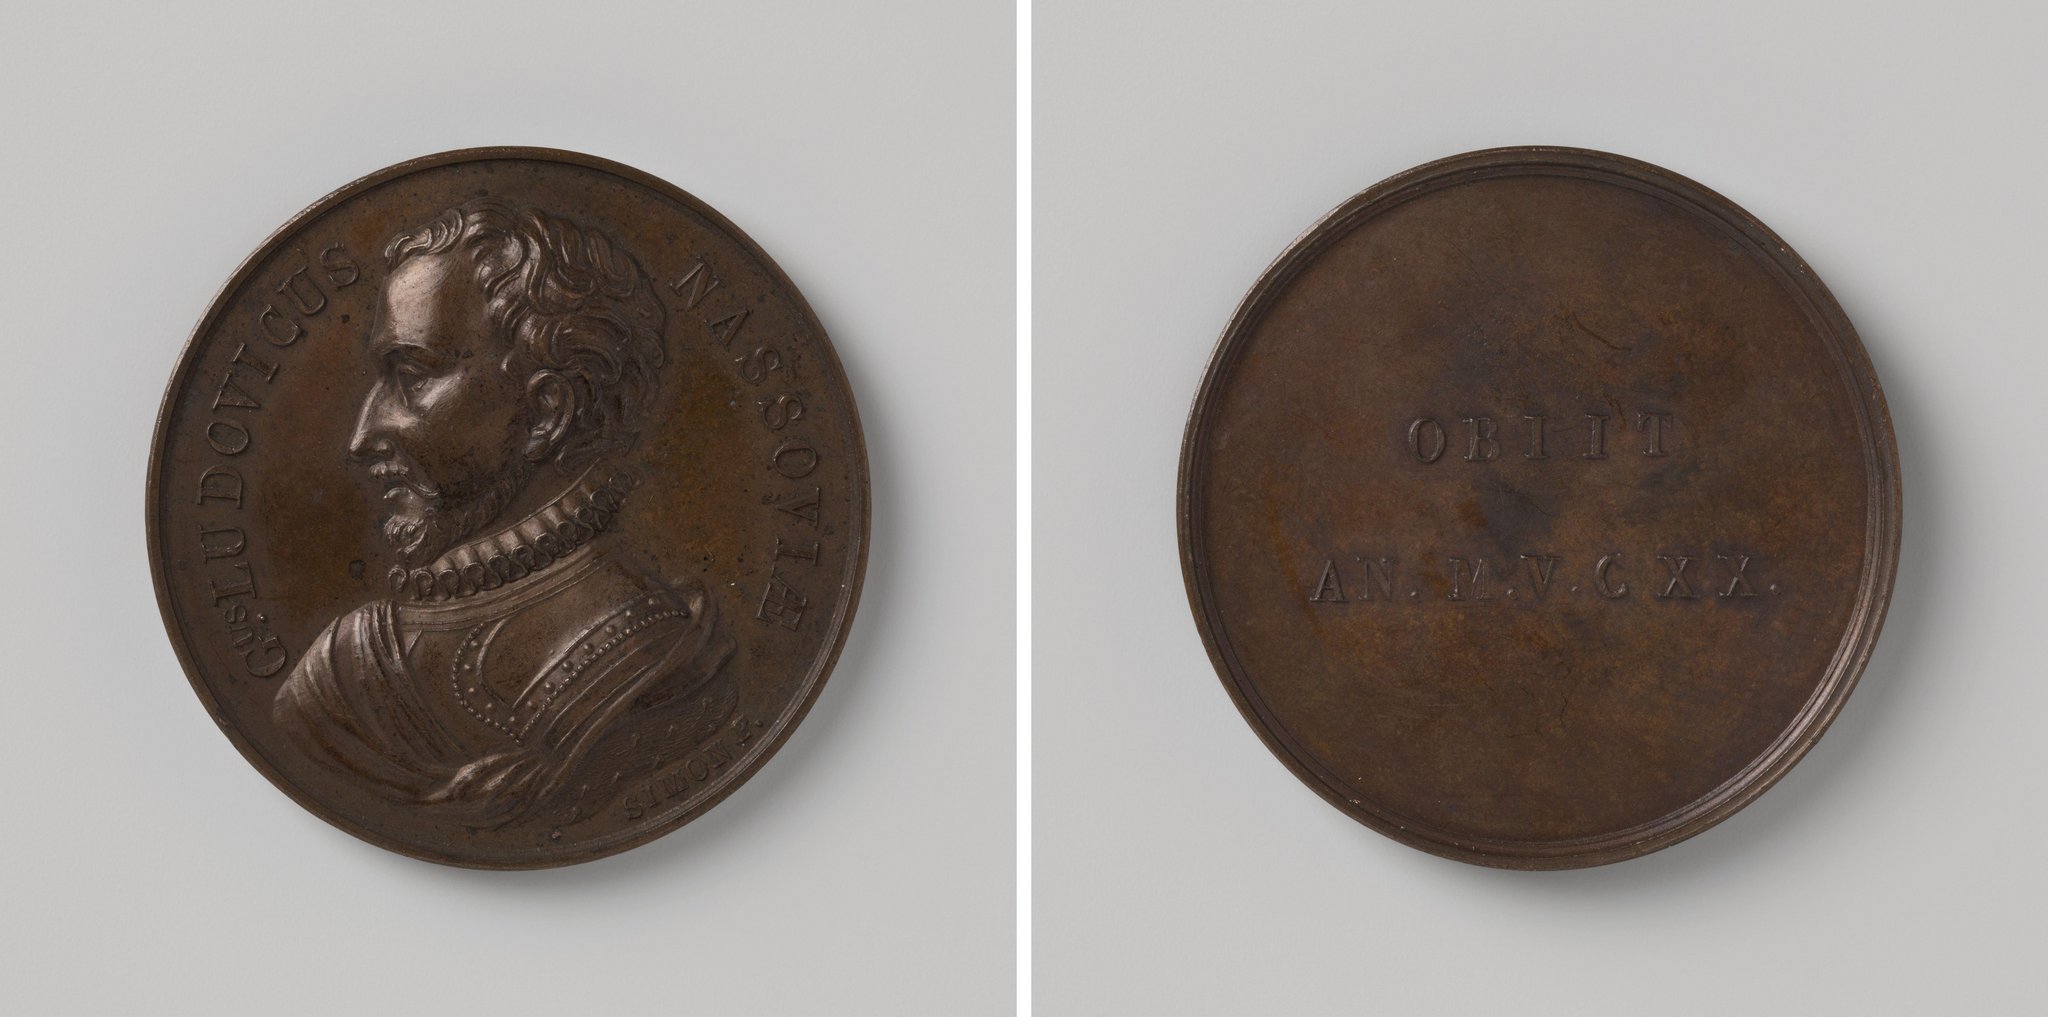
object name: history medal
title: Dood van graaf Willem Lodewijk van Nassau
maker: jean henri simon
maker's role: medailleur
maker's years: 1752-1834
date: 1816-1834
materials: bronze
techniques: striking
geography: brussels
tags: willem lodewijk graaf van nassau-dillenburg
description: Bronzen penning. Voorzijde: borststuk man. Keerzijde: opschrift.